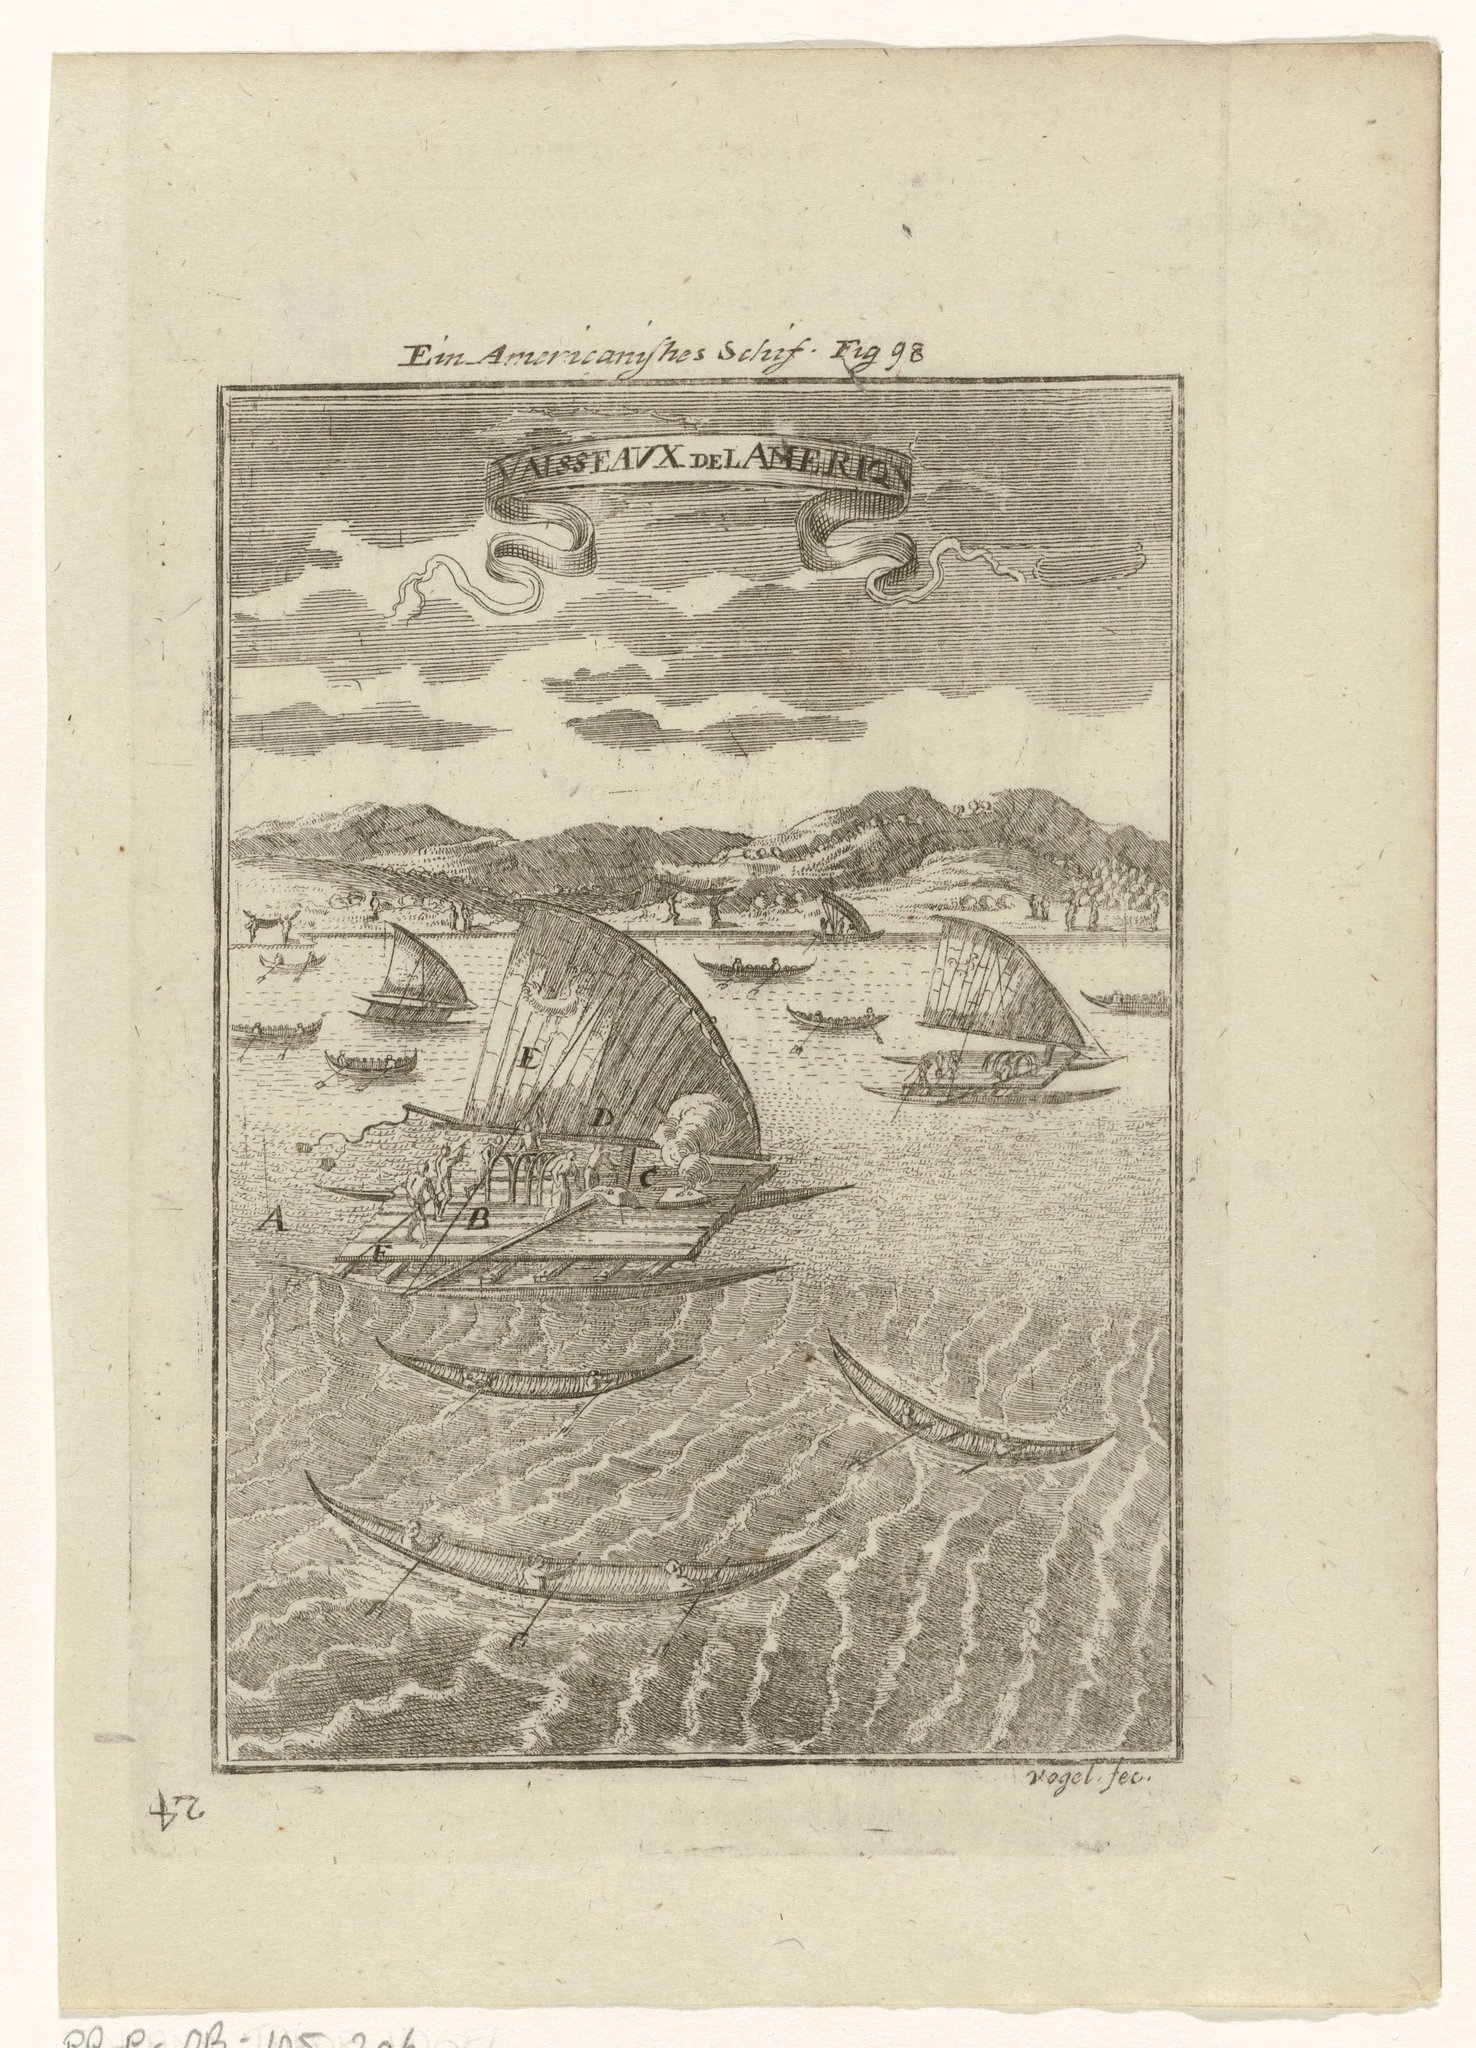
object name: book illustration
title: Amerikaanse schepen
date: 1719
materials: paper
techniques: etching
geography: frankfurt am main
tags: sailing-ship, sailing-boat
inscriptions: collector's mark: Lugt 2228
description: Boekillustratie uit: Mallet, Allain Manesson. Allain Manesson Mallets Beschreibung des gantzen Welt-Kreises. [Vertaald uit het Frans.] Frankkfurt am Main: Johann Adam Jung, 1719. De boekillustraties in deze uitgave zijn gekopieerd naar de boekillustraties in de originele Franse uitgave: Mallet, Allain Manesson. Description de l'univers. Parijs: Denis Thierry, 1683.